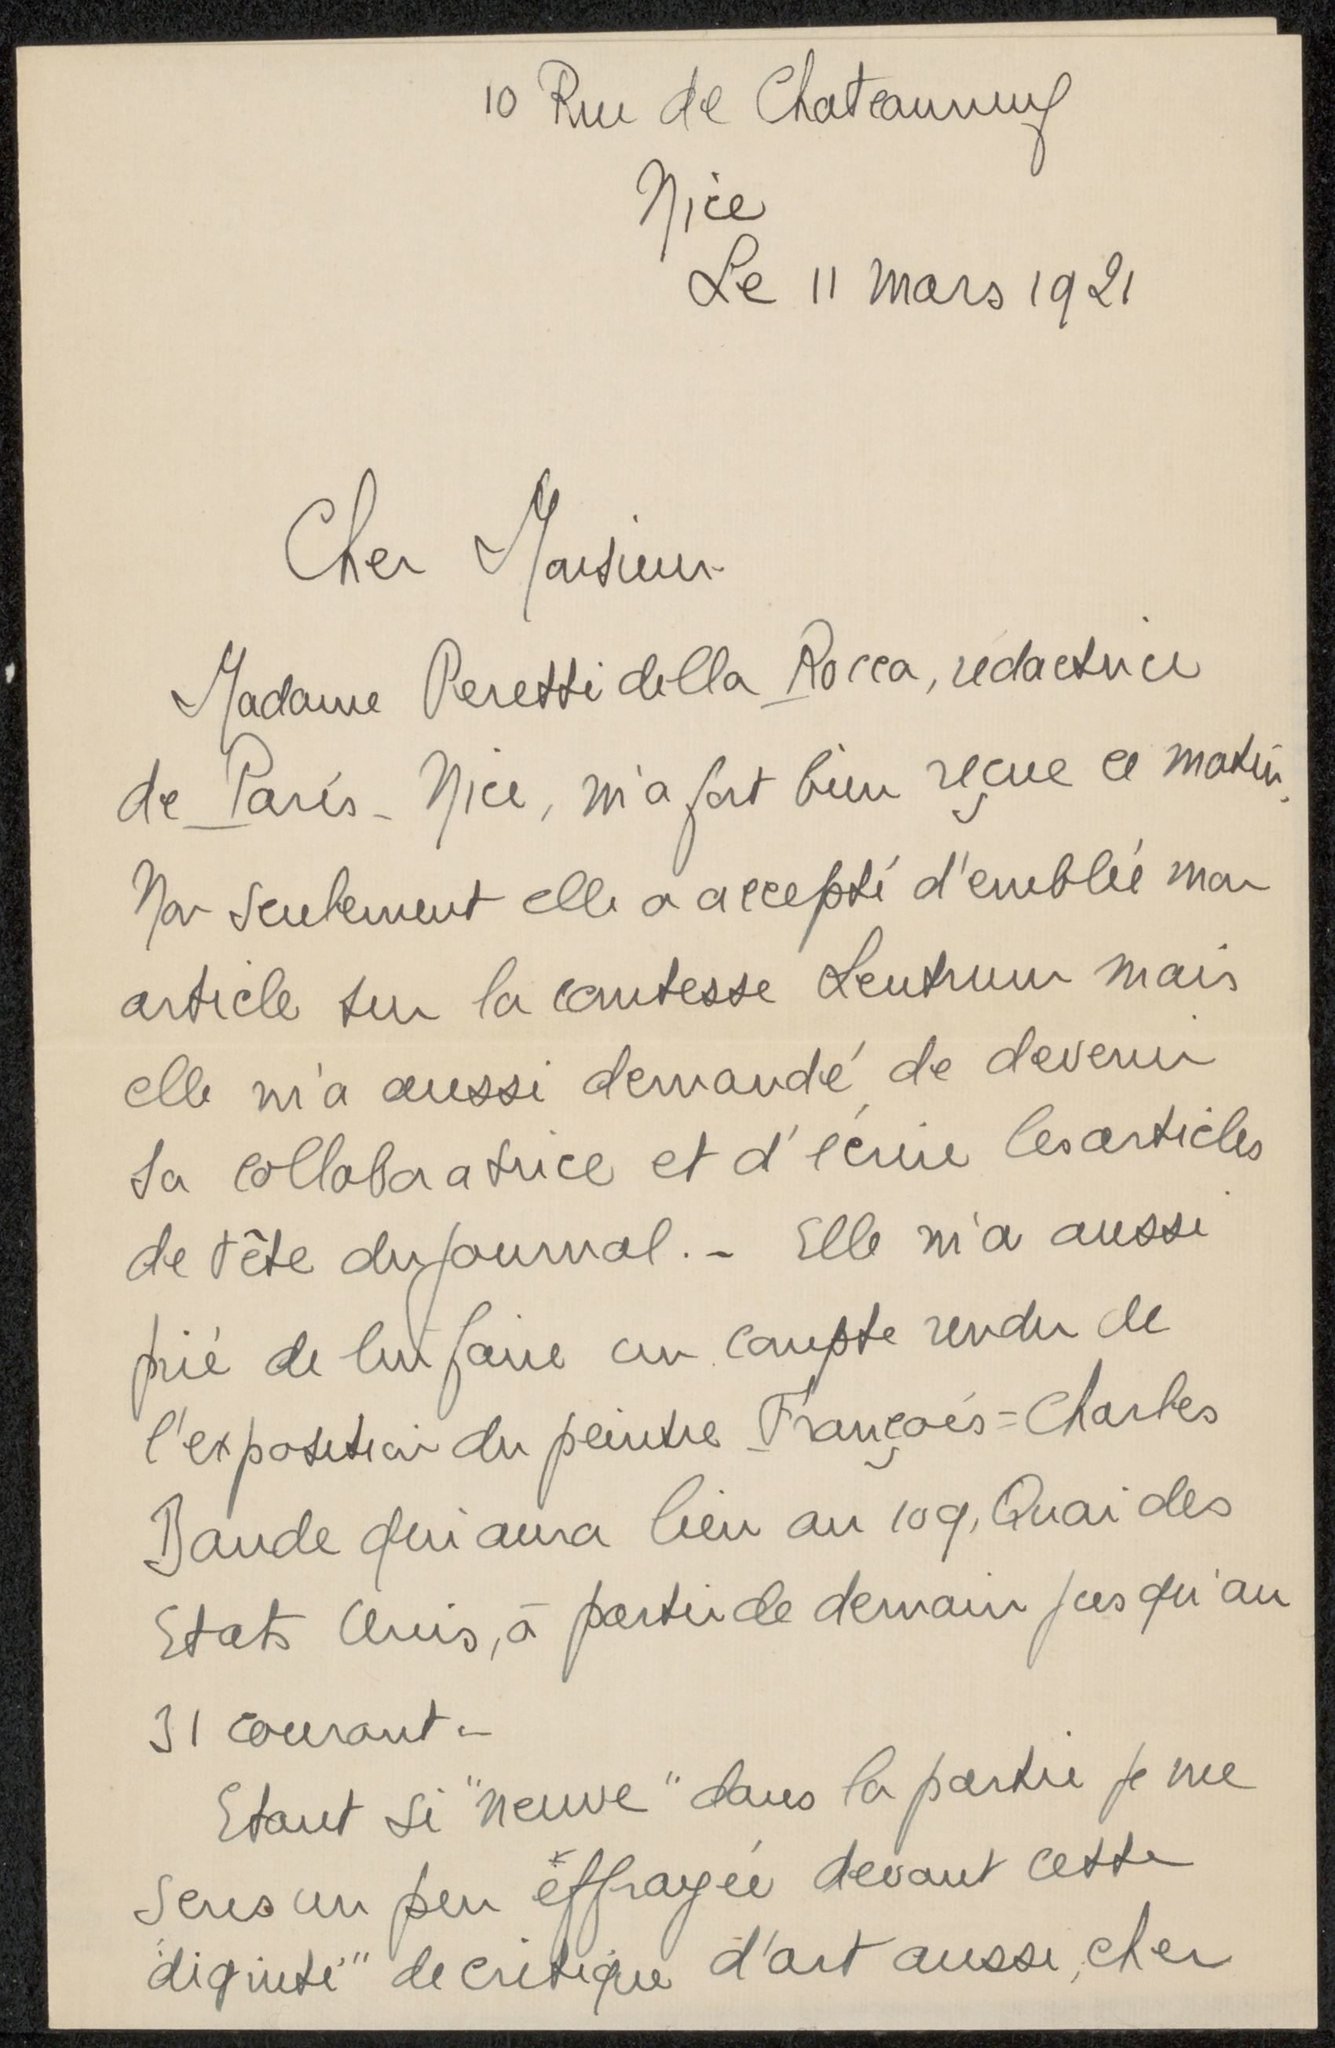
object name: letter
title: Brief aan Philip Zilcken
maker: jeanne erlich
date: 1921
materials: ink, paper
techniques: pen, writing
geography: nice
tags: charles baude, the hague, painter, draughtsman, philip zilcken, temporary exhibition, 'salon'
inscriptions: collector's mark: ‘RPK’, watermark